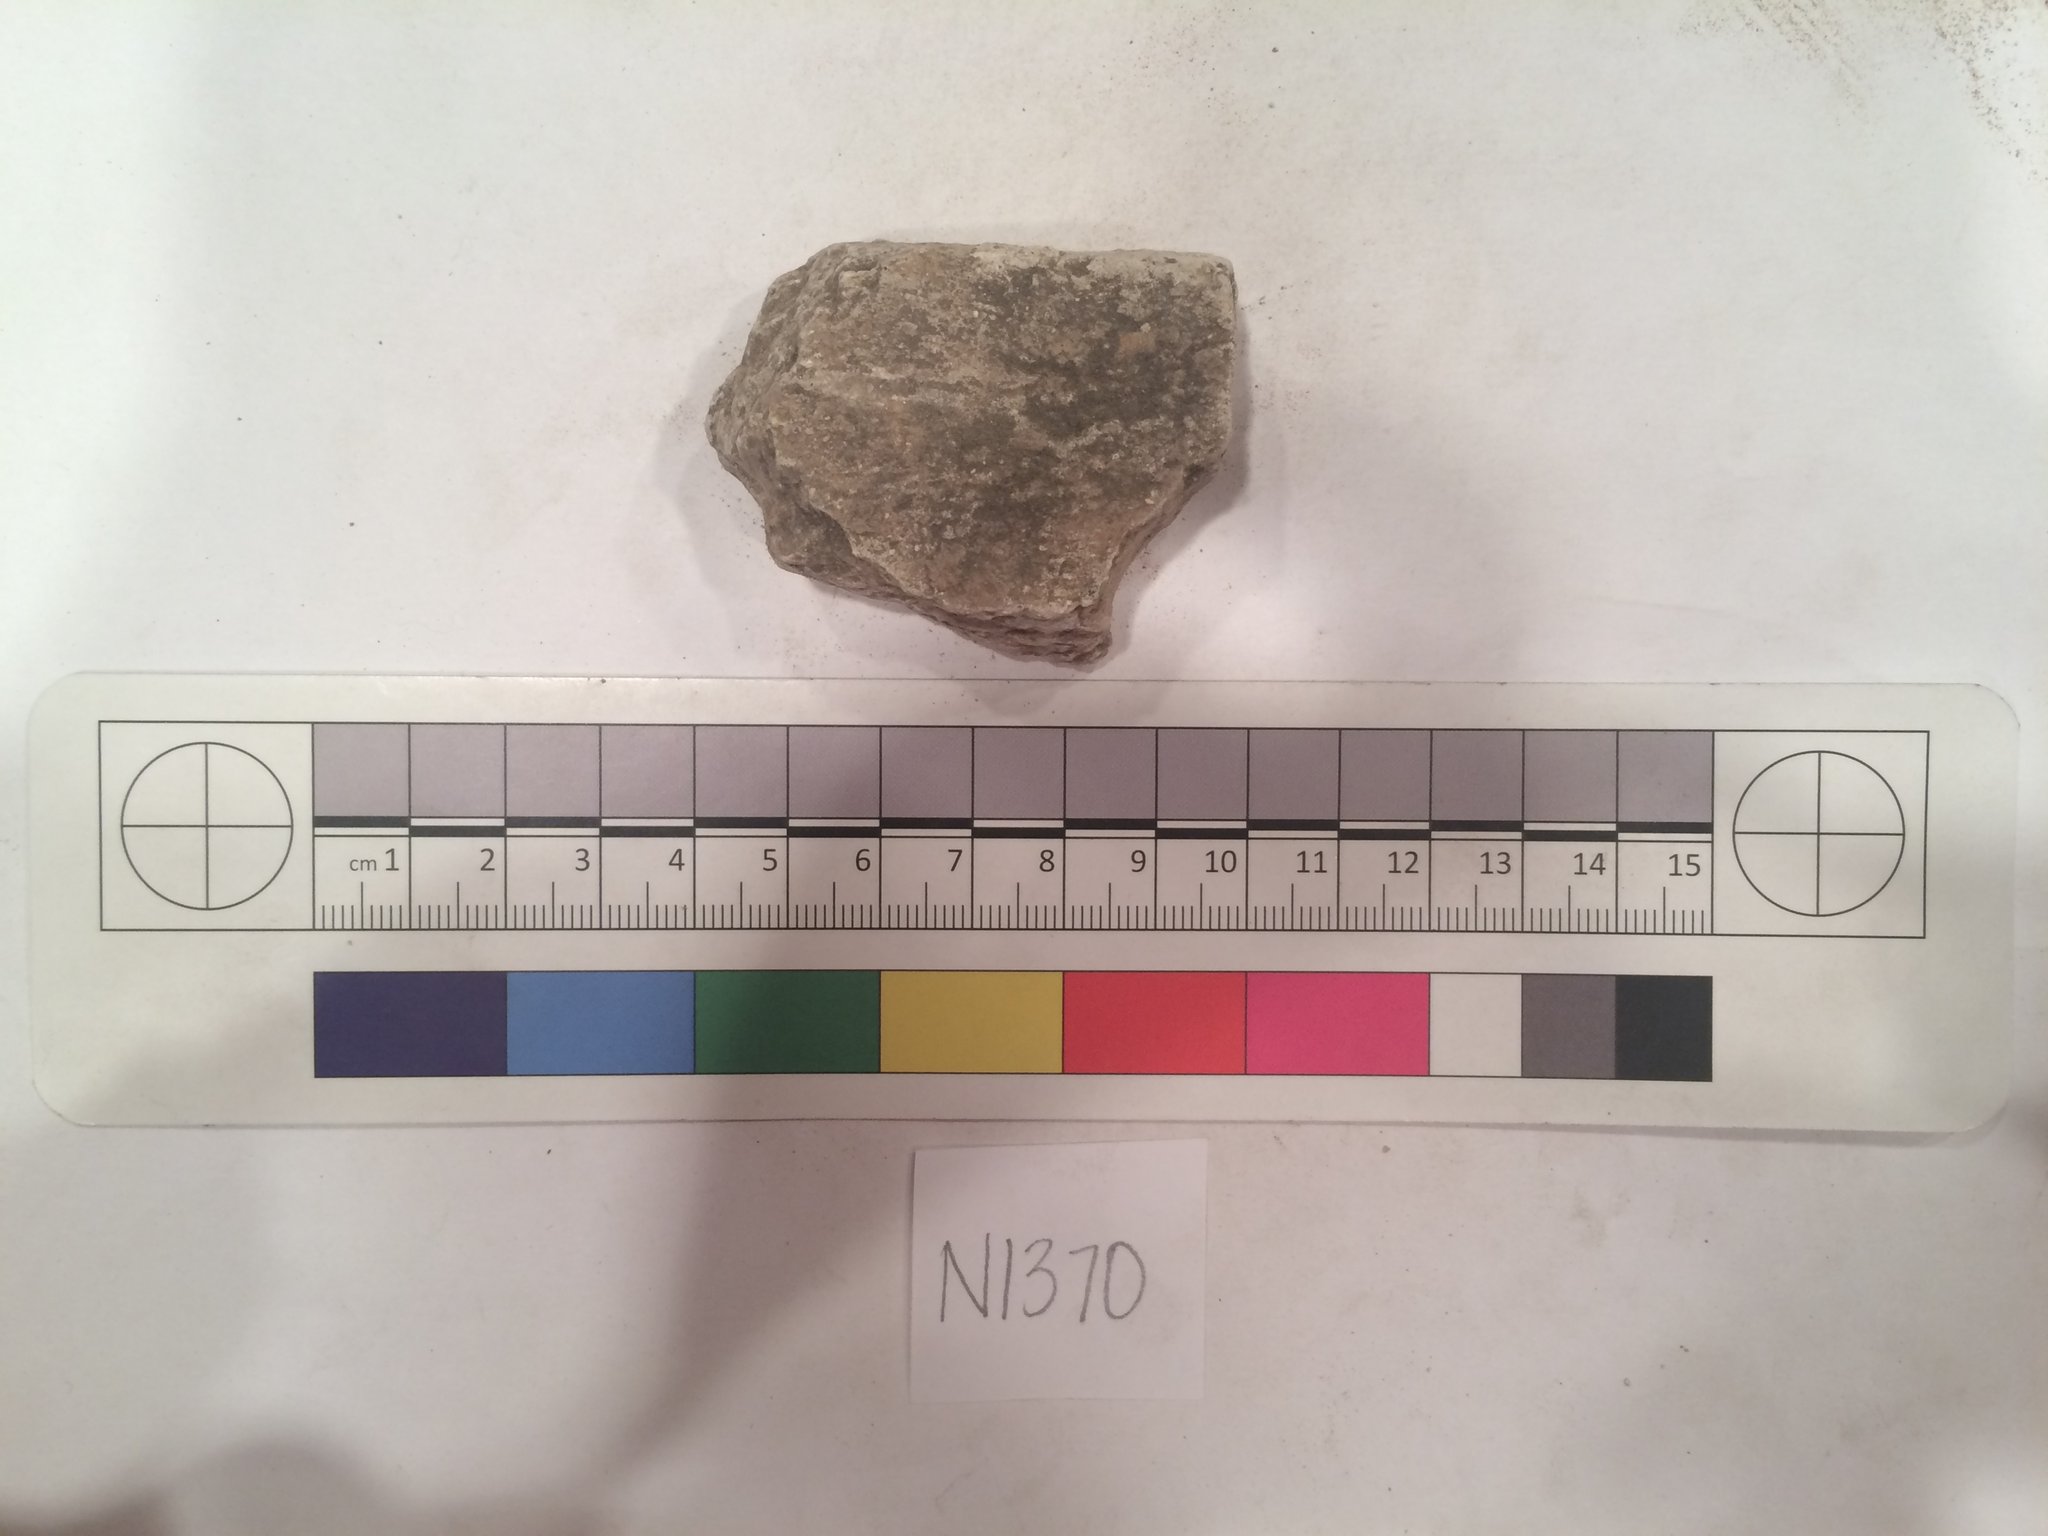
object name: fragment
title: Stucco Fragment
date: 701-1200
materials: plaster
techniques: carving, painting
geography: iran